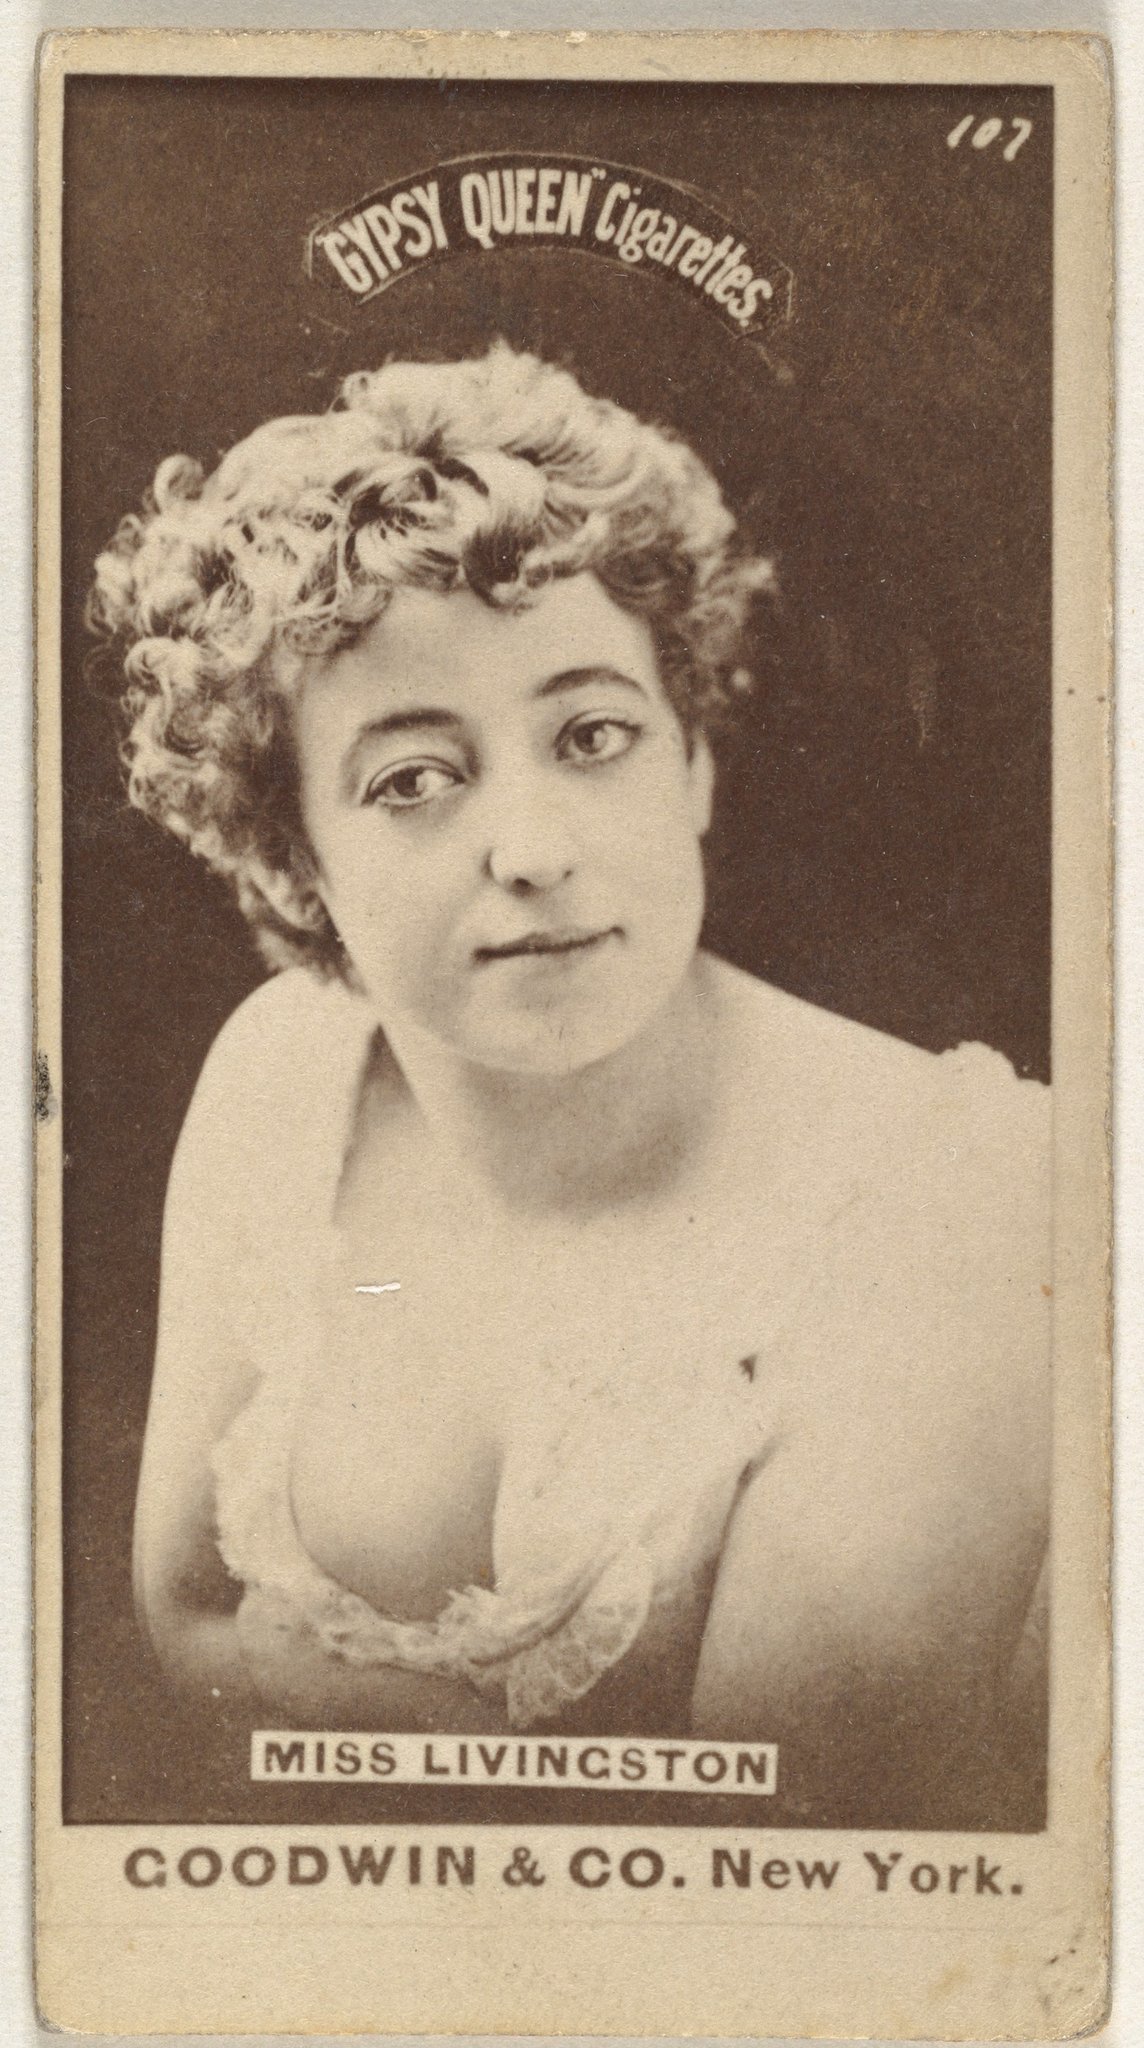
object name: photograph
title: Miss Livingston, from the Actors and Actresses series (N171) for Gypsy Queen Cigarettes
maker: goodwin & company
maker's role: publisher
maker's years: 1850-1950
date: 1886-1890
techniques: albumen silver print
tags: portraits,women,actresses